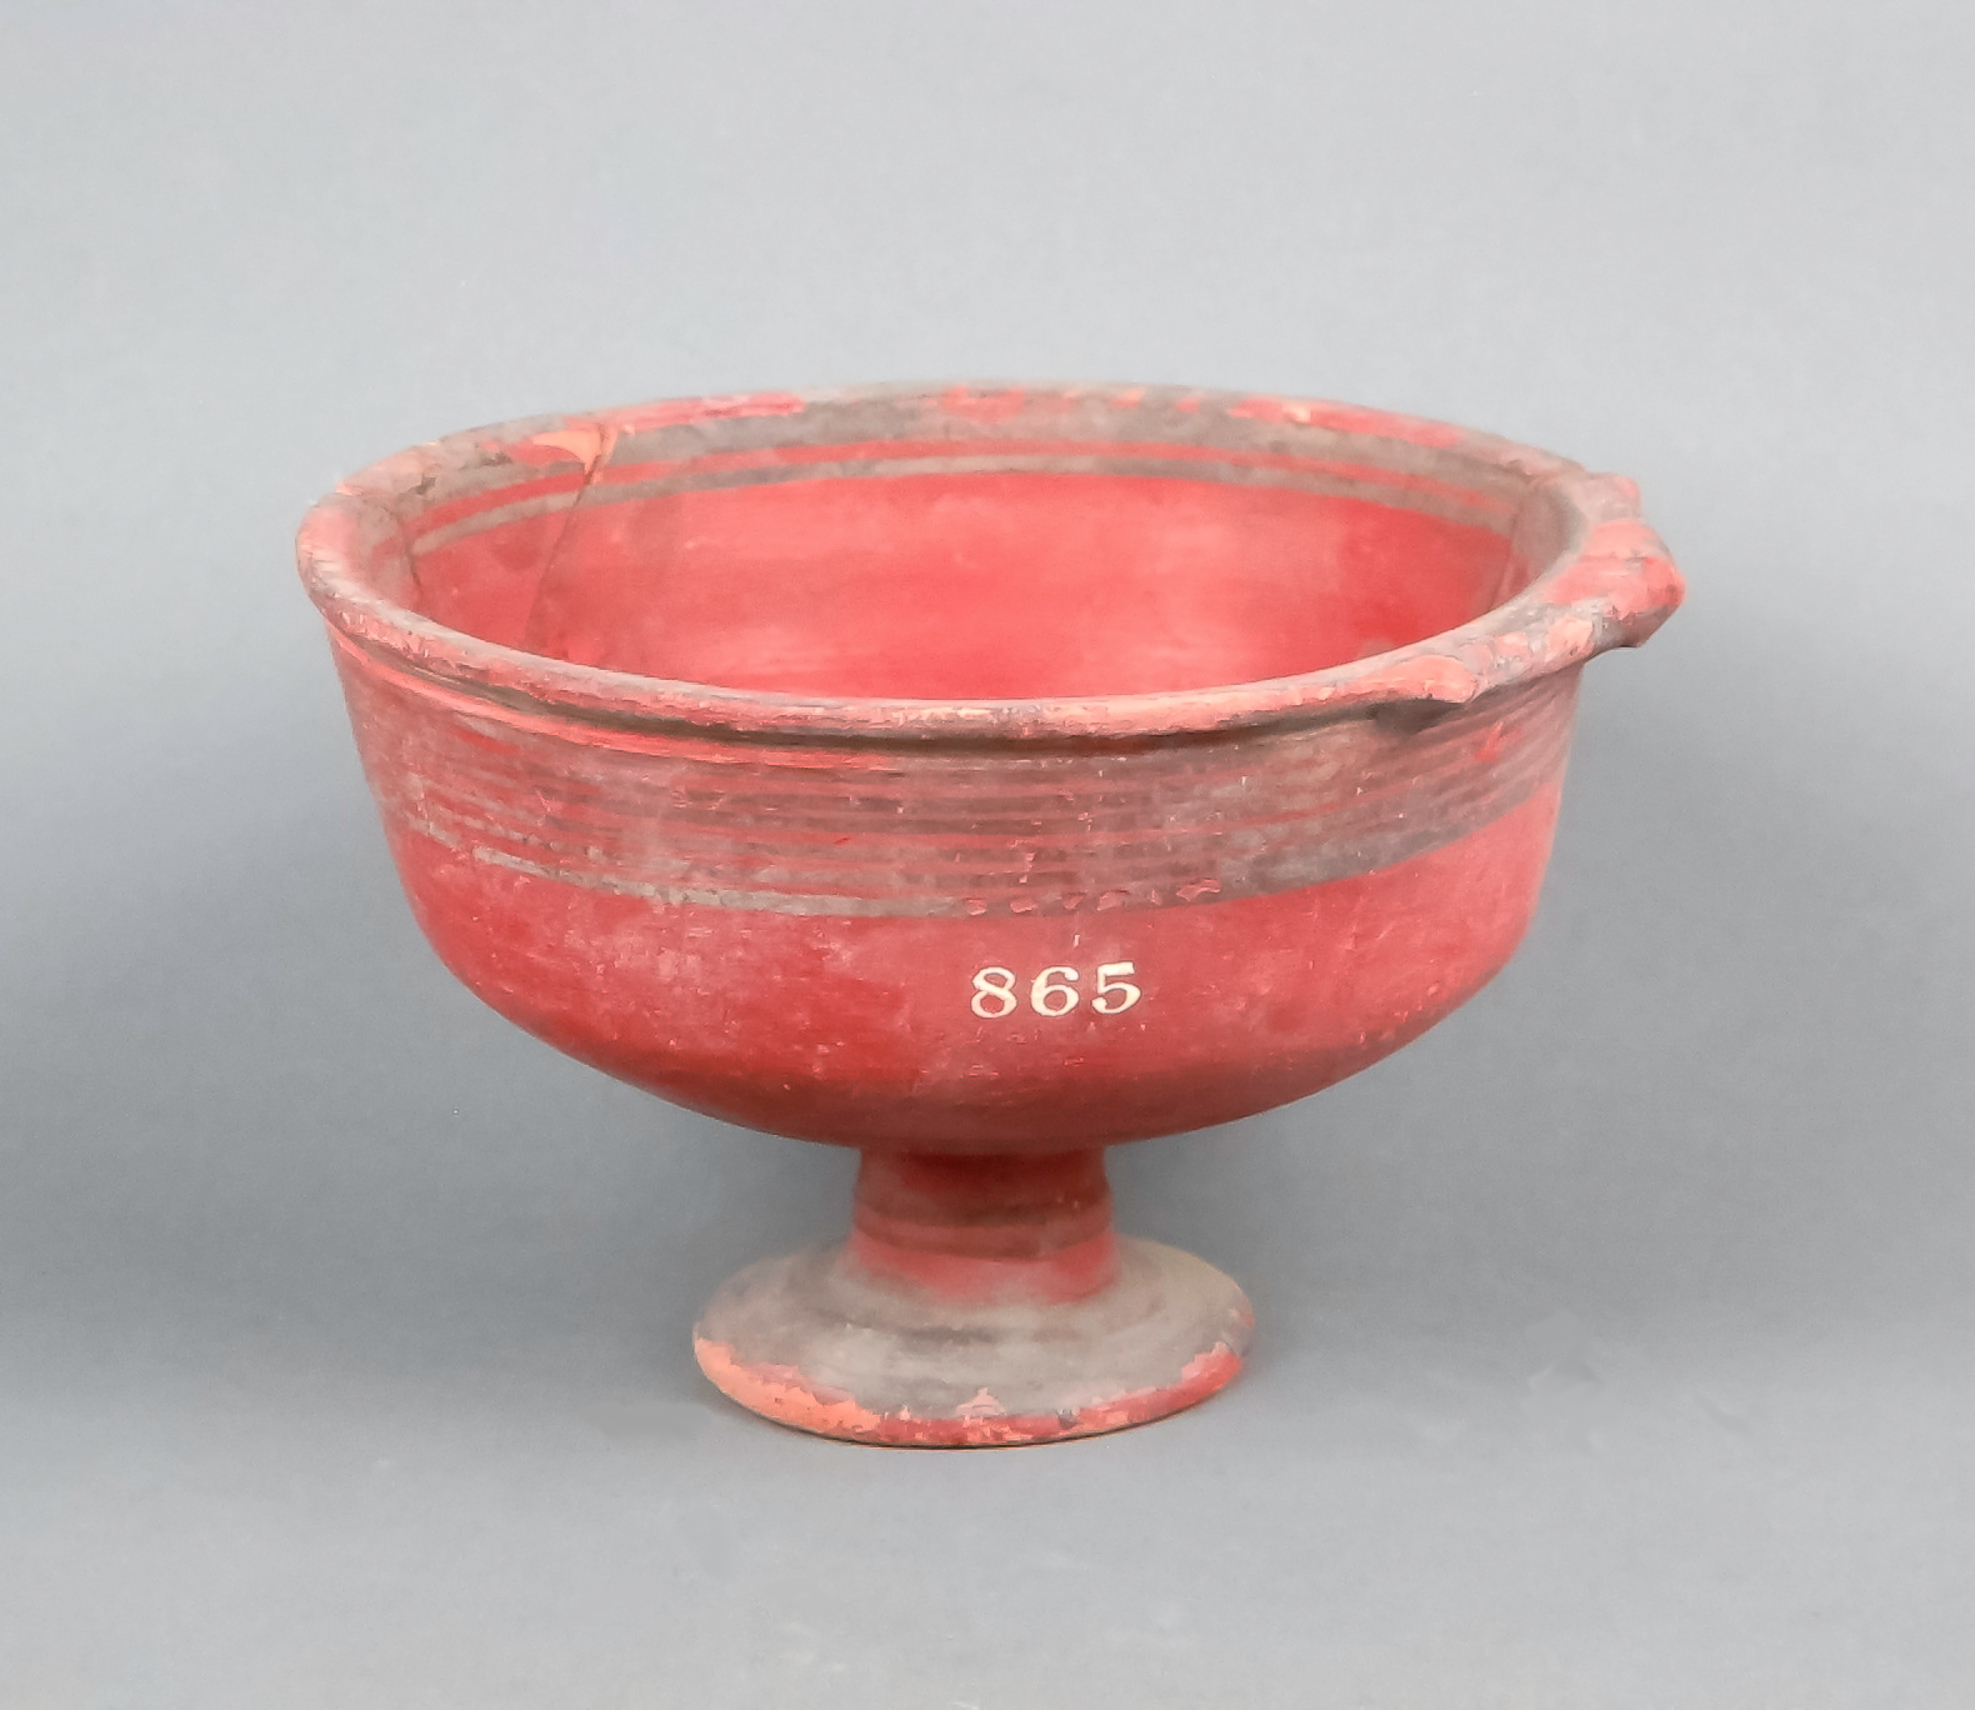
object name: bowl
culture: cypriot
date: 1125-1050 BCE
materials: terracotta